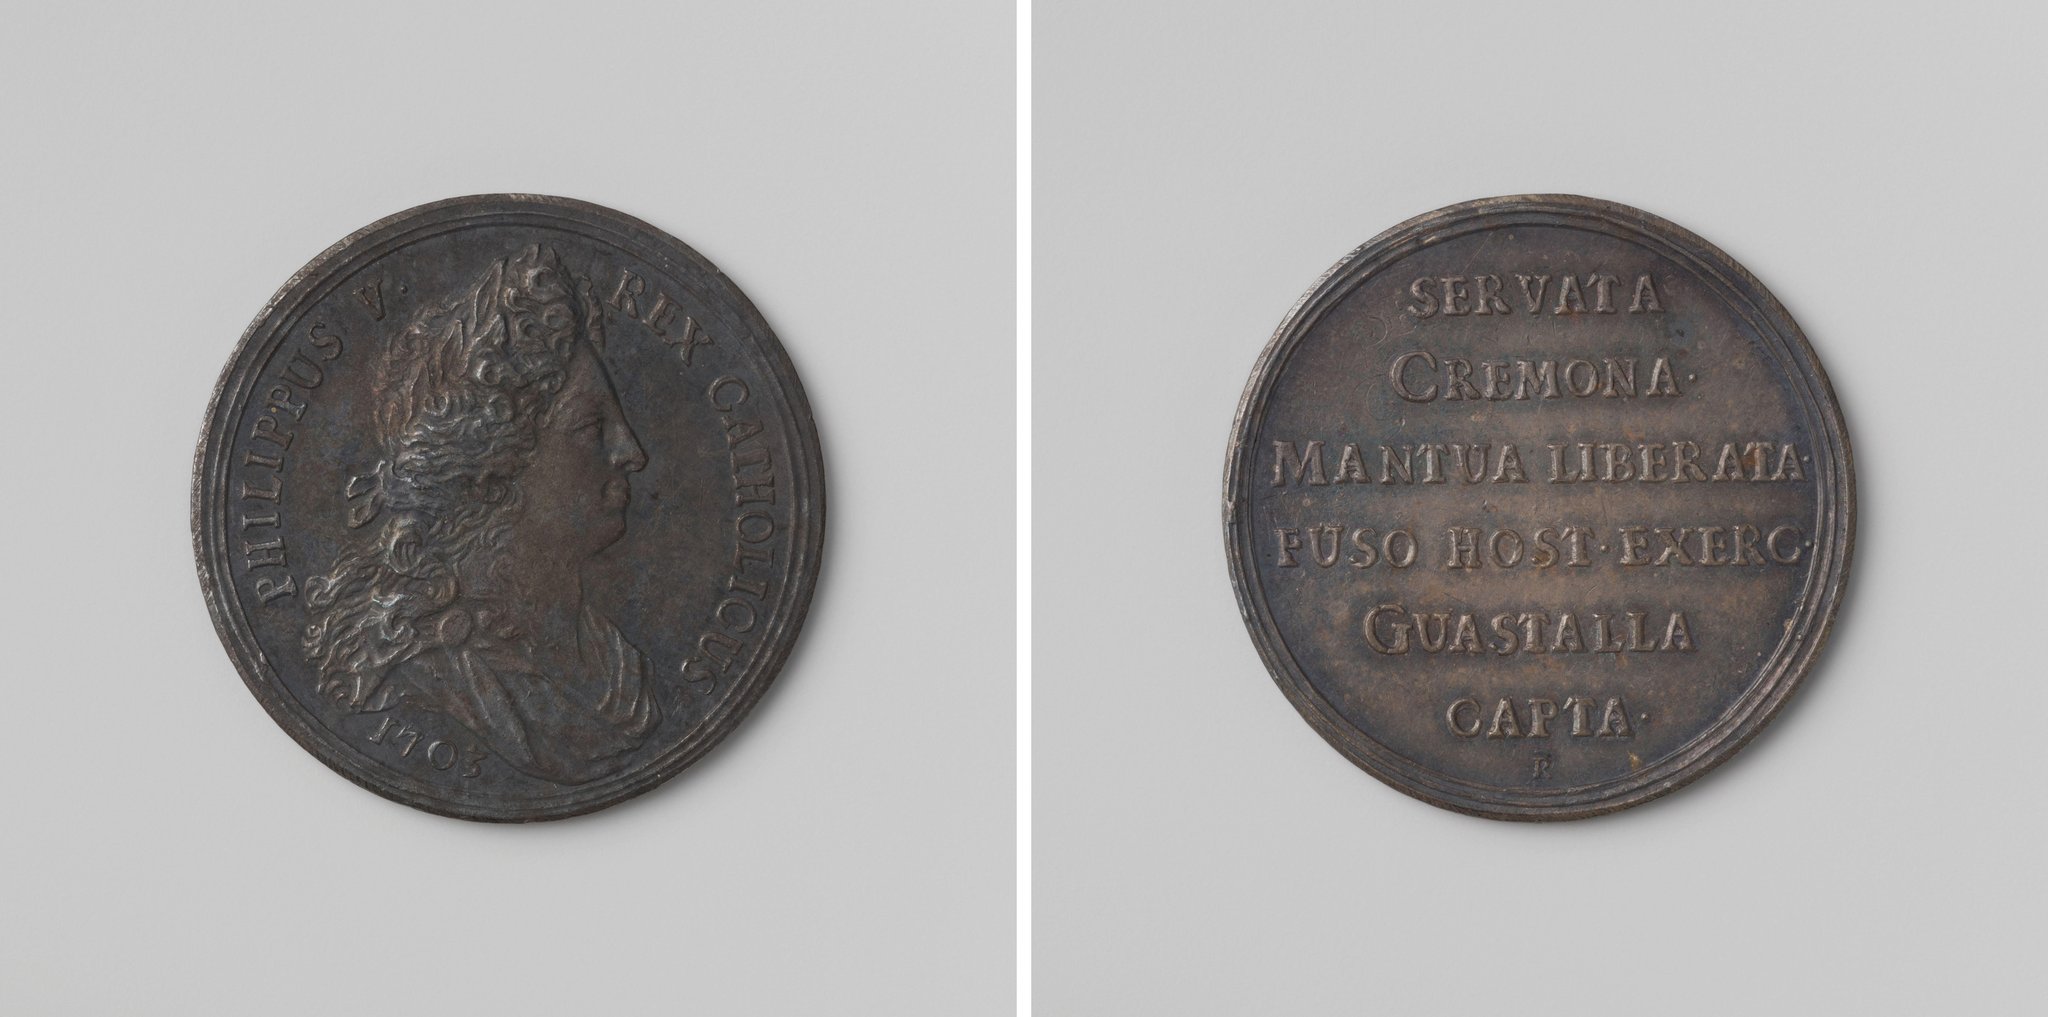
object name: jeton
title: Behoud van Cremona, ontzet van Mantua en inname van Guastalla, rekenpenning geslagen ter ere van Filips V, koning van Spanje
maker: philippe roëttiers (ii)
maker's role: medailleur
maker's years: 1640-1718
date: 1702-1703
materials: silver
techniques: striking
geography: antwerp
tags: filips v (koning van spanje)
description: Zilveren penning. Voorzijde: borststuk man met lauwerkrans binnen omschrift. Keerzijde: opschrift.